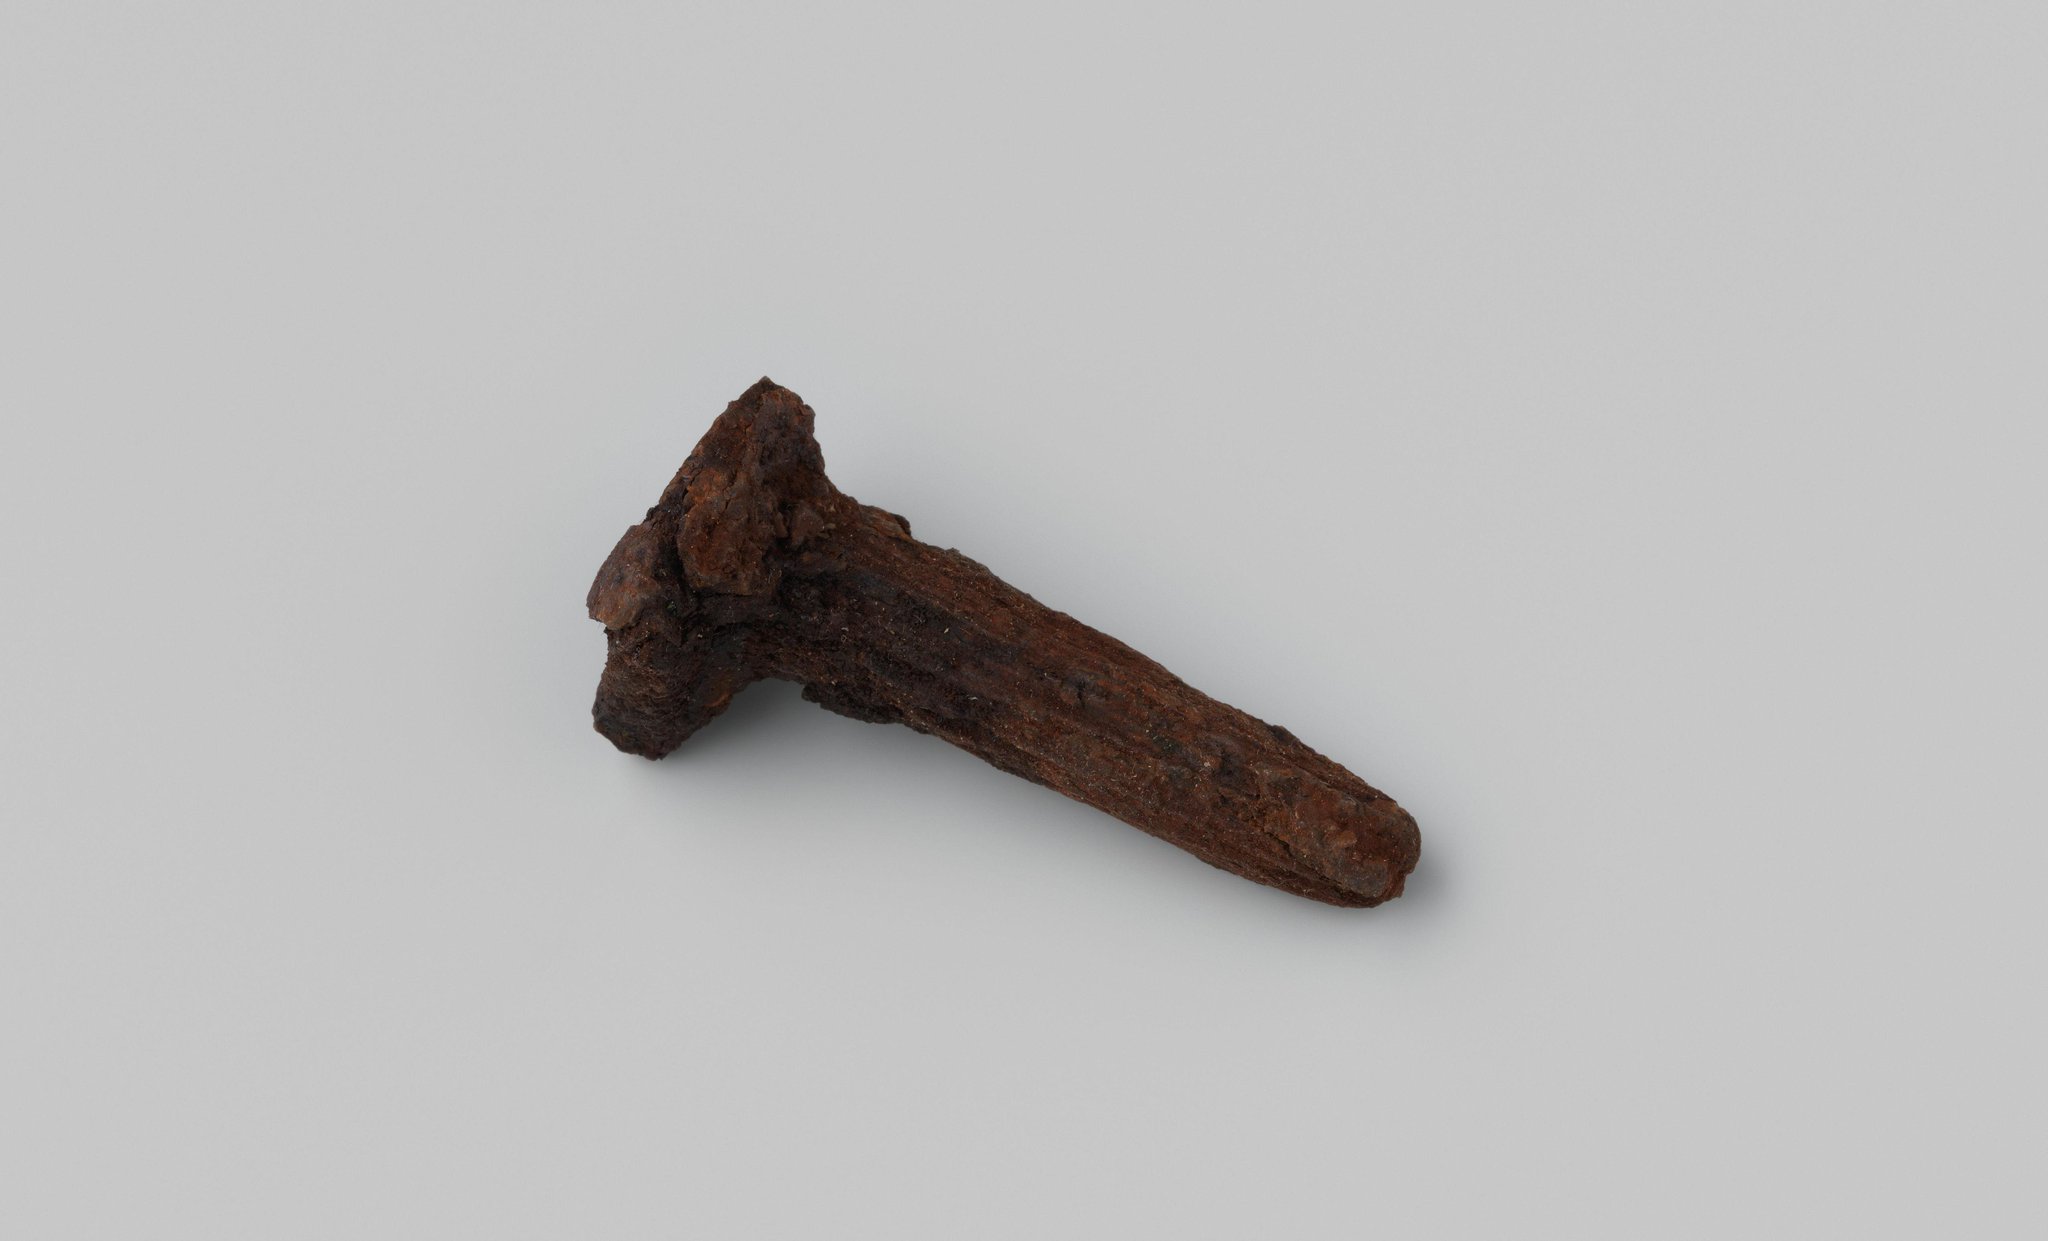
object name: bolt tongs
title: Bout afkomstig uit het wrak van de Oost-Indiëvaarder Hollandia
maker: Anonymous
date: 1700-1743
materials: iron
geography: netherlands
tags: verenigde oostindische compagnie, hollandia (schip)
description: Bolts; fragm, corroded, shaft circular in section, tapering, broken off, flat square head.